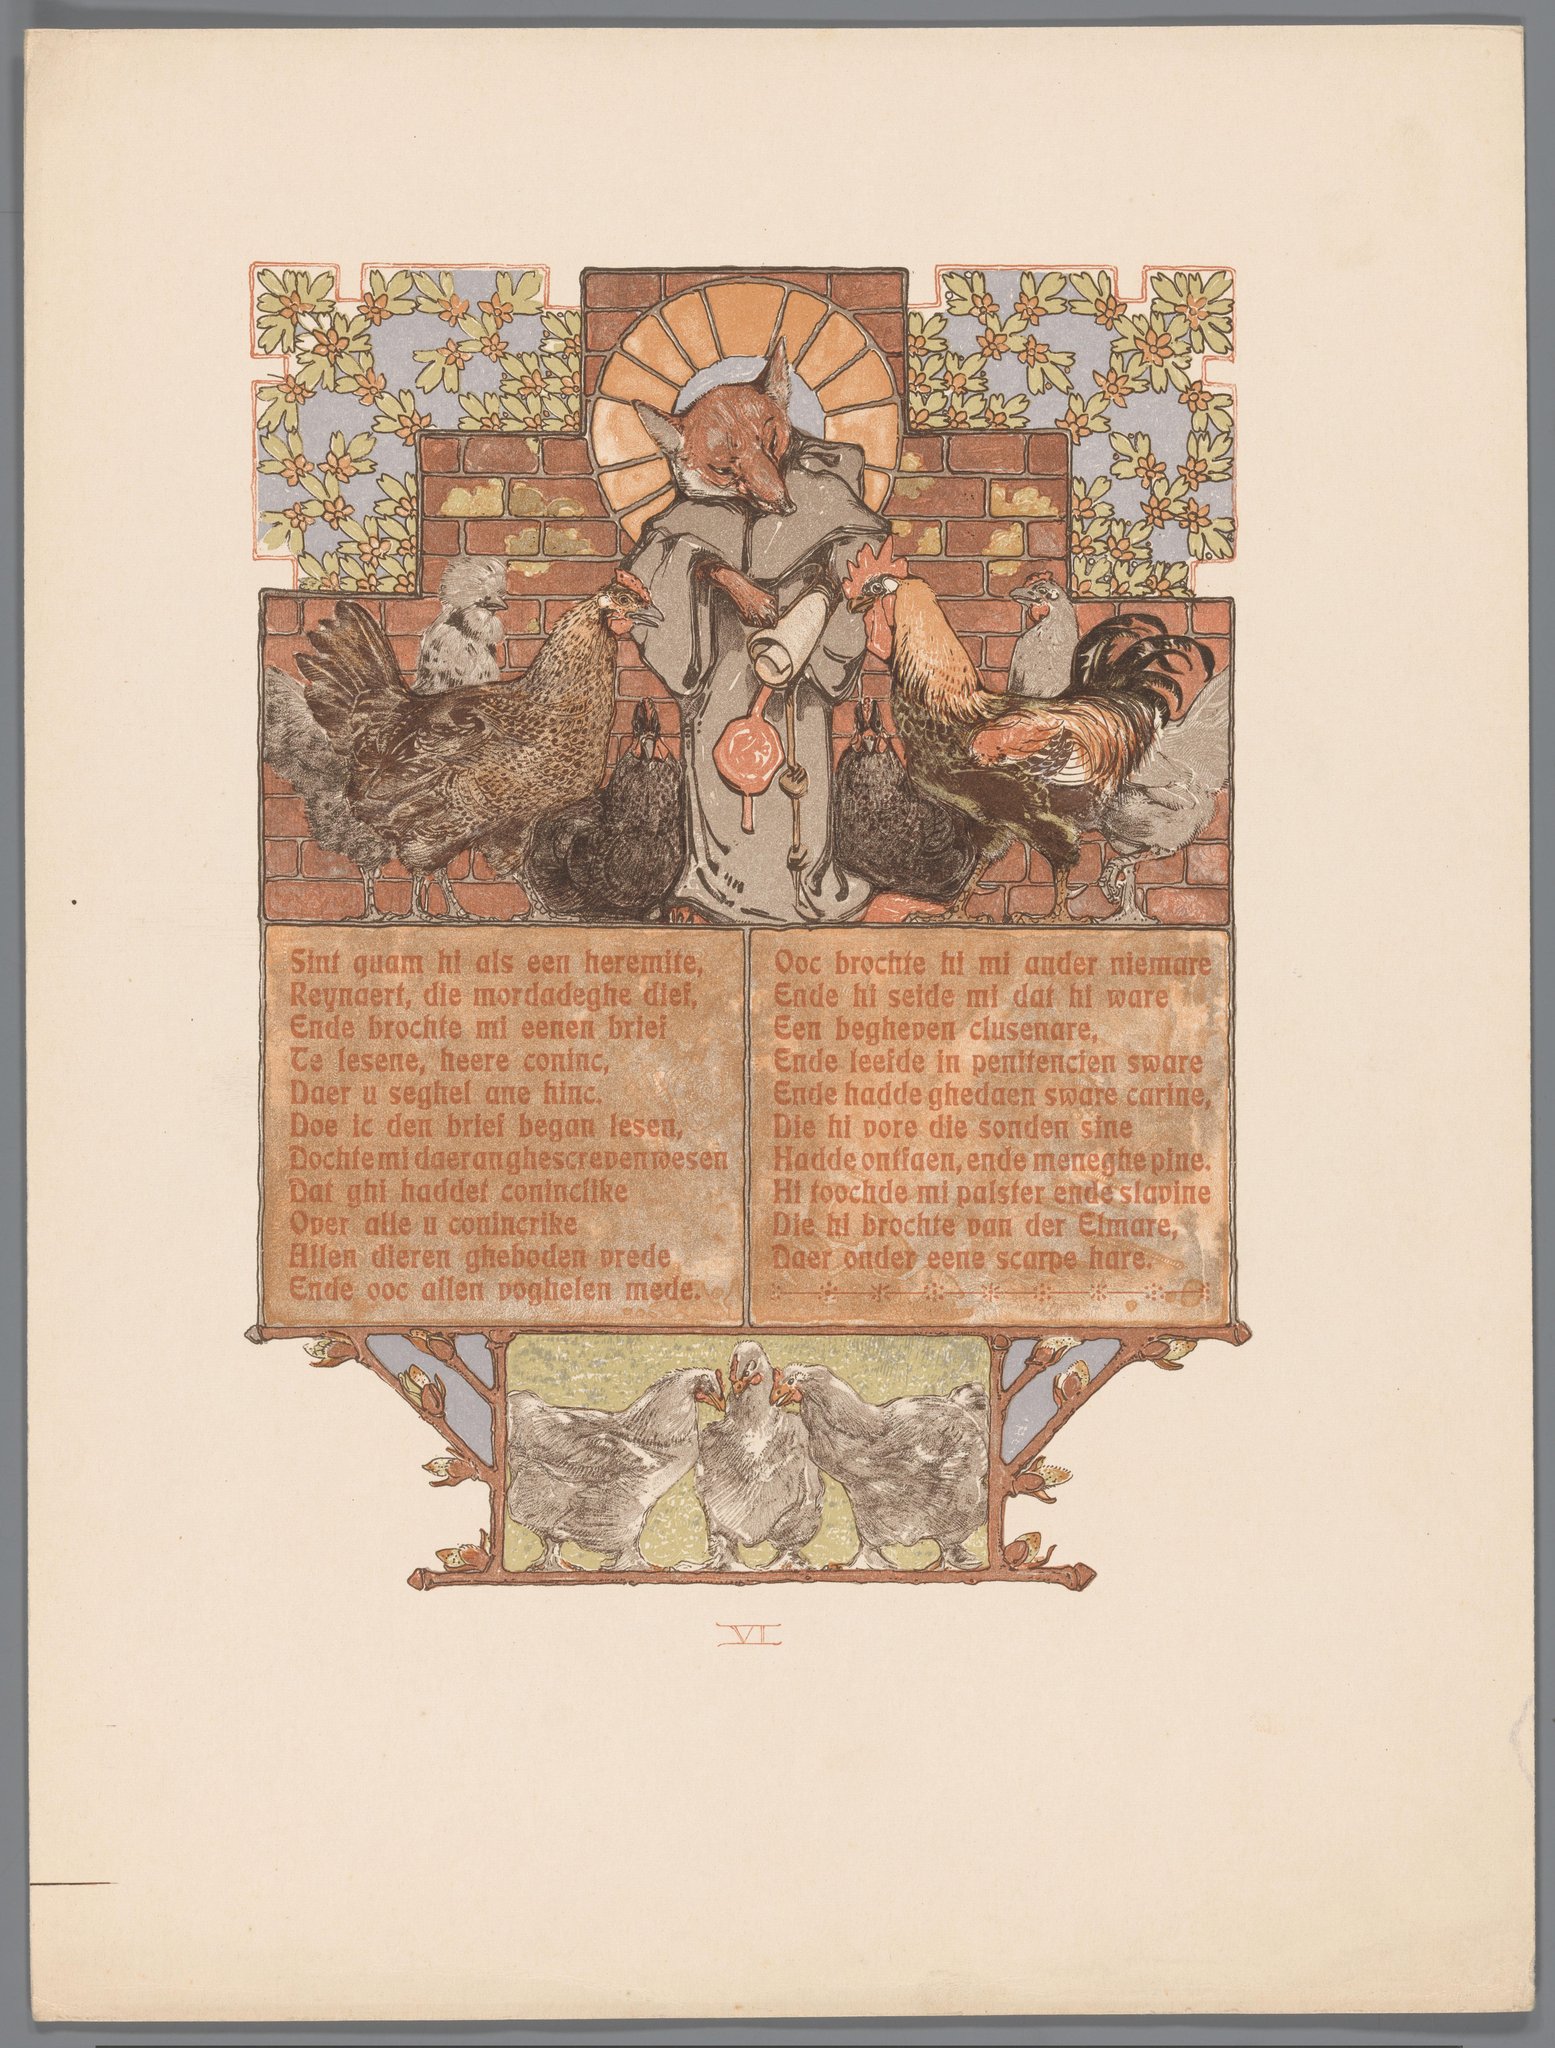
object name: print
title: Vos in monnikspij (Reinaert) omringd door kippen en haan (Cantecleer)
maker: bernard willem wierink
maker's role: draughtsman, print maker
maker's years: 1856-1939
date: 1910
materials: paper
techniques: lithograph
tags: fable of reynard the fox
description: Prent gebruikt in: Streuvels, Stijn (Frank Lateur). Reinaert de Vos naar verschillende uitgaven van het middeleeuwsche epos. Amsterdam: L.J. Veen, 1910.